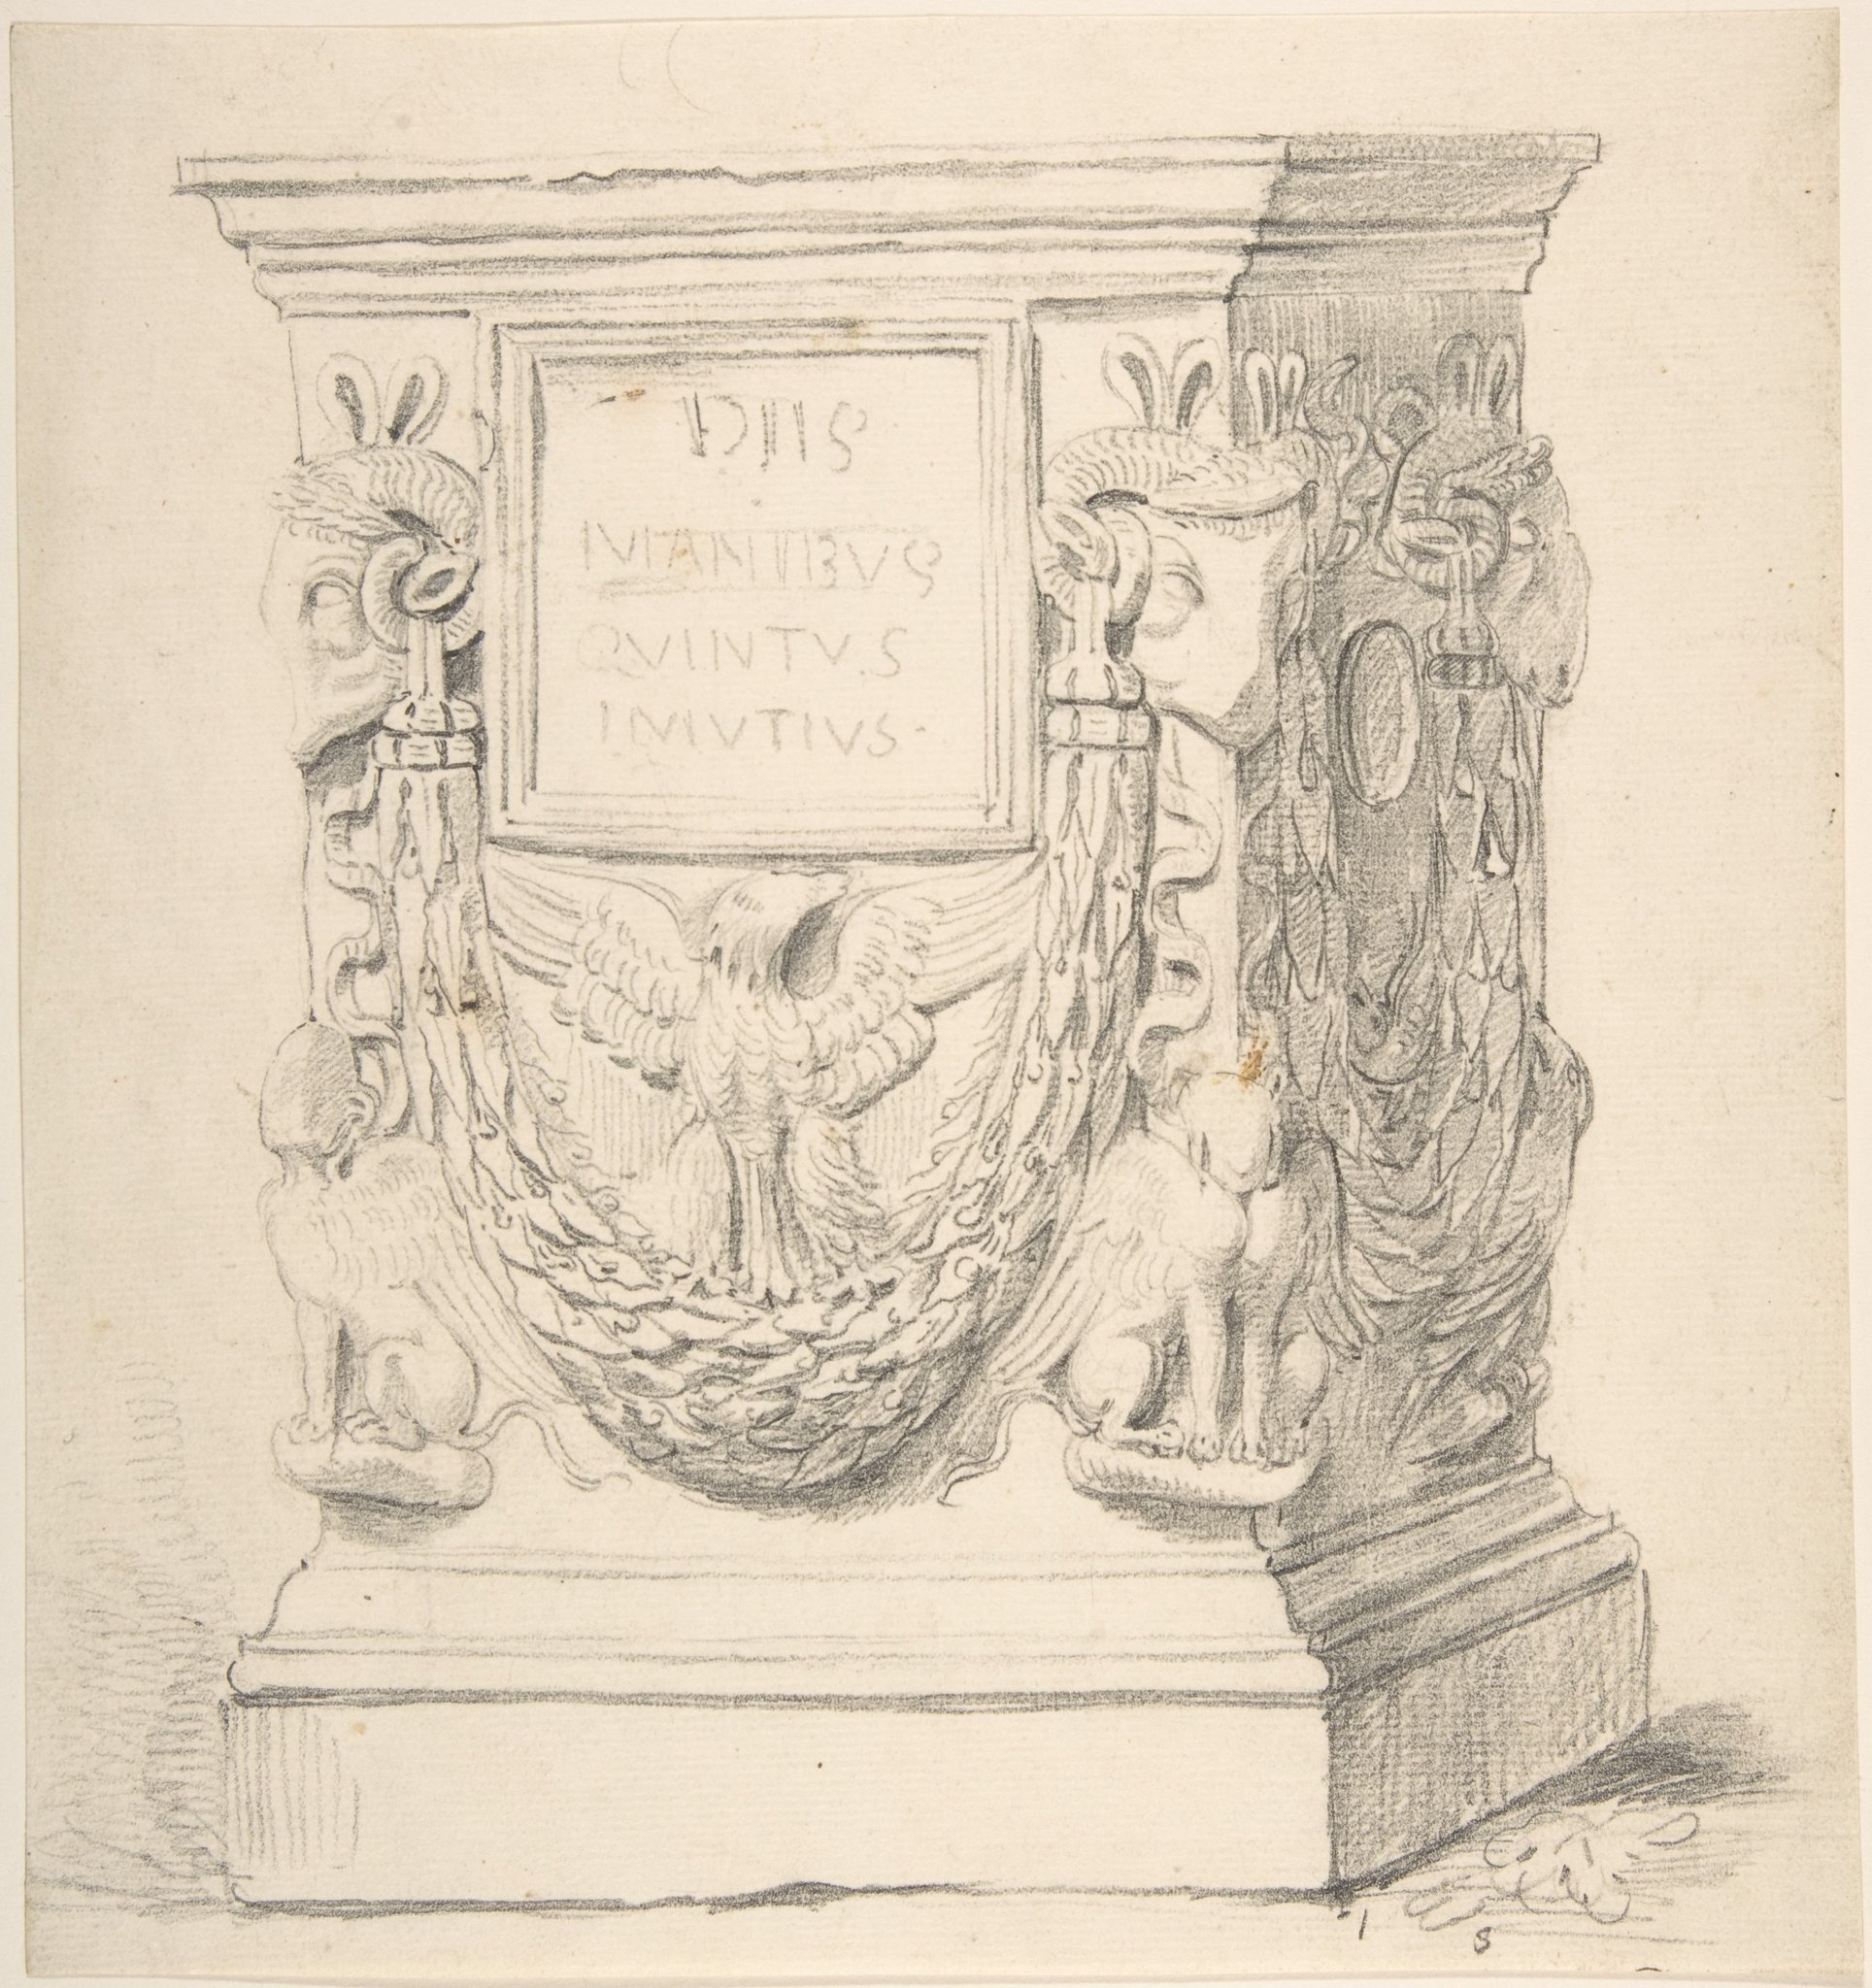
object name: drawing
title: Sketch of a Classical Pedestal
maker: thomas hardwick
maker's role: artist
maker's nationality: british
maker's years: 1752-1829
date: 1776-1779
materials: graphite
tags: coat of arms